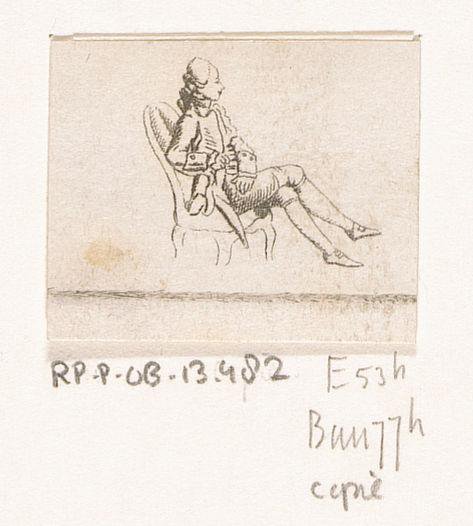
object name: print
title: Man in een leunstoel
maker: Anonymous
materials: paper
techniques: etching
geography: berlin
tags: armchair, seat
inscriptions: collector's mark: Lugt 2228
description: De serie met negen schetsen die Chodowiecki maakte in de randen van de koperplaat met illustraties voor de Duitse versie van Minna van Barnhelm werd twee keer gekopieerd.